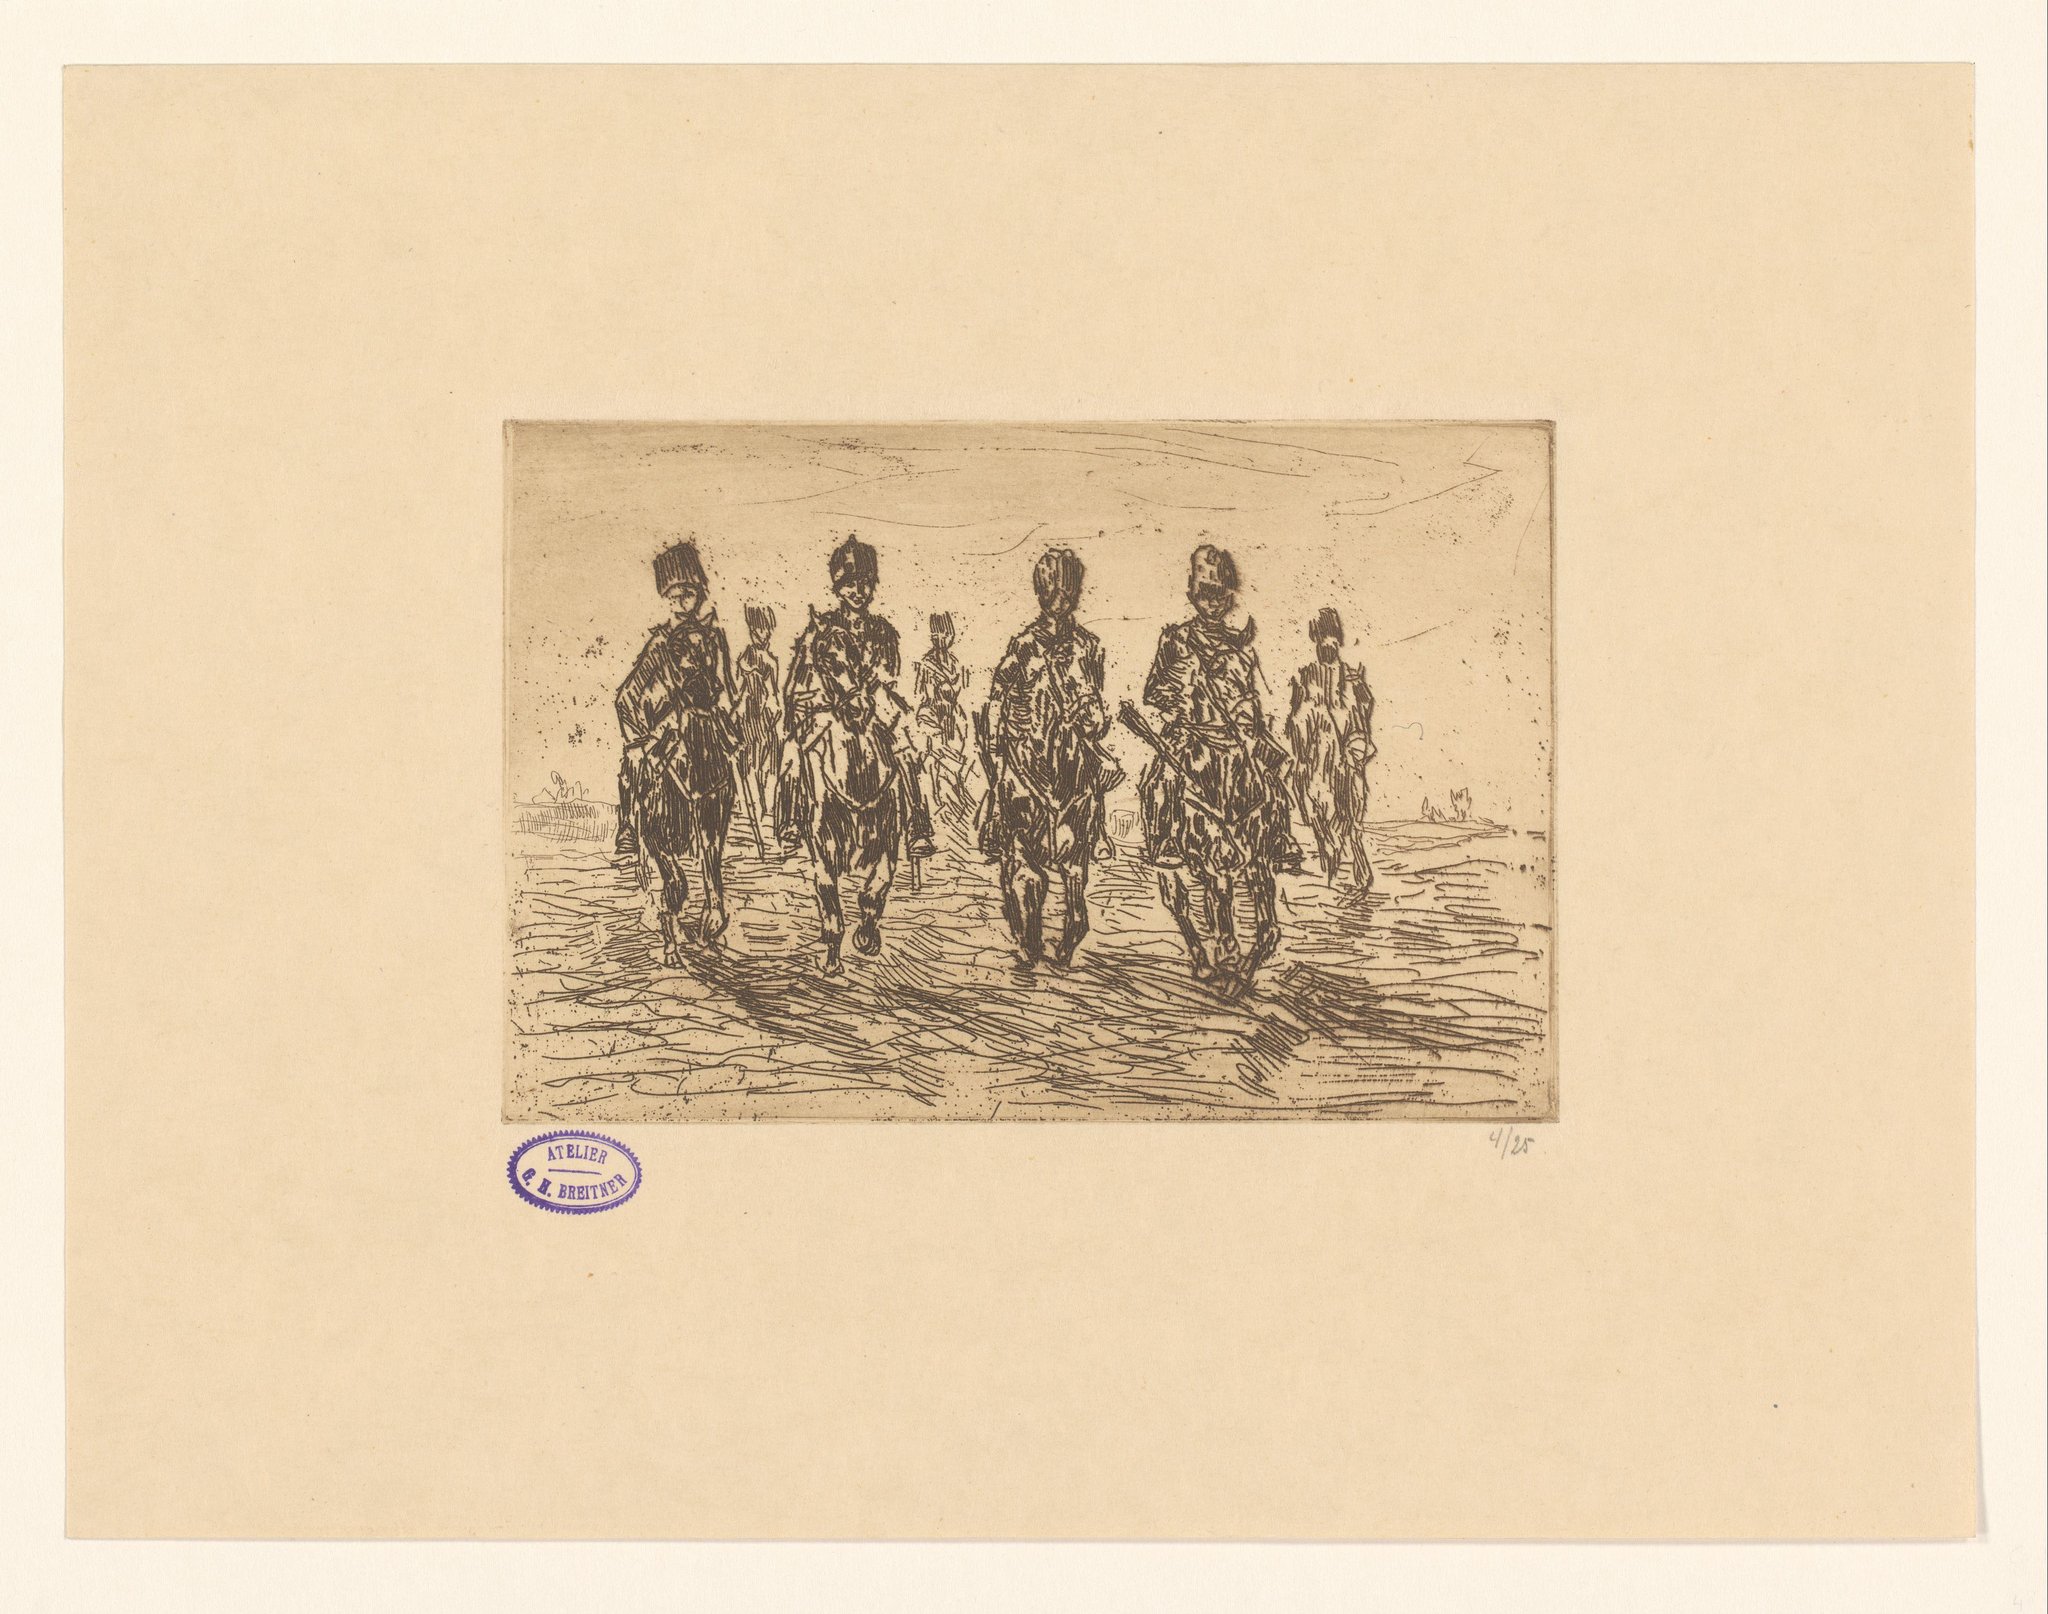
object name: print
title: Huzaren in galop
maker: george hendrik breitner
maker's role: draughtsman, painter, print maker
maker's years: 1857-1923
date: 1893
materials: paper, ink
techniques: etching, intaglio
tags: private soldier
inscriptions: workshop stamp: Lugt 291d, collector's mark: Lugt 2228, edition: ‘4/25’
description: Zeven huzaren in galop, van voren gezien.